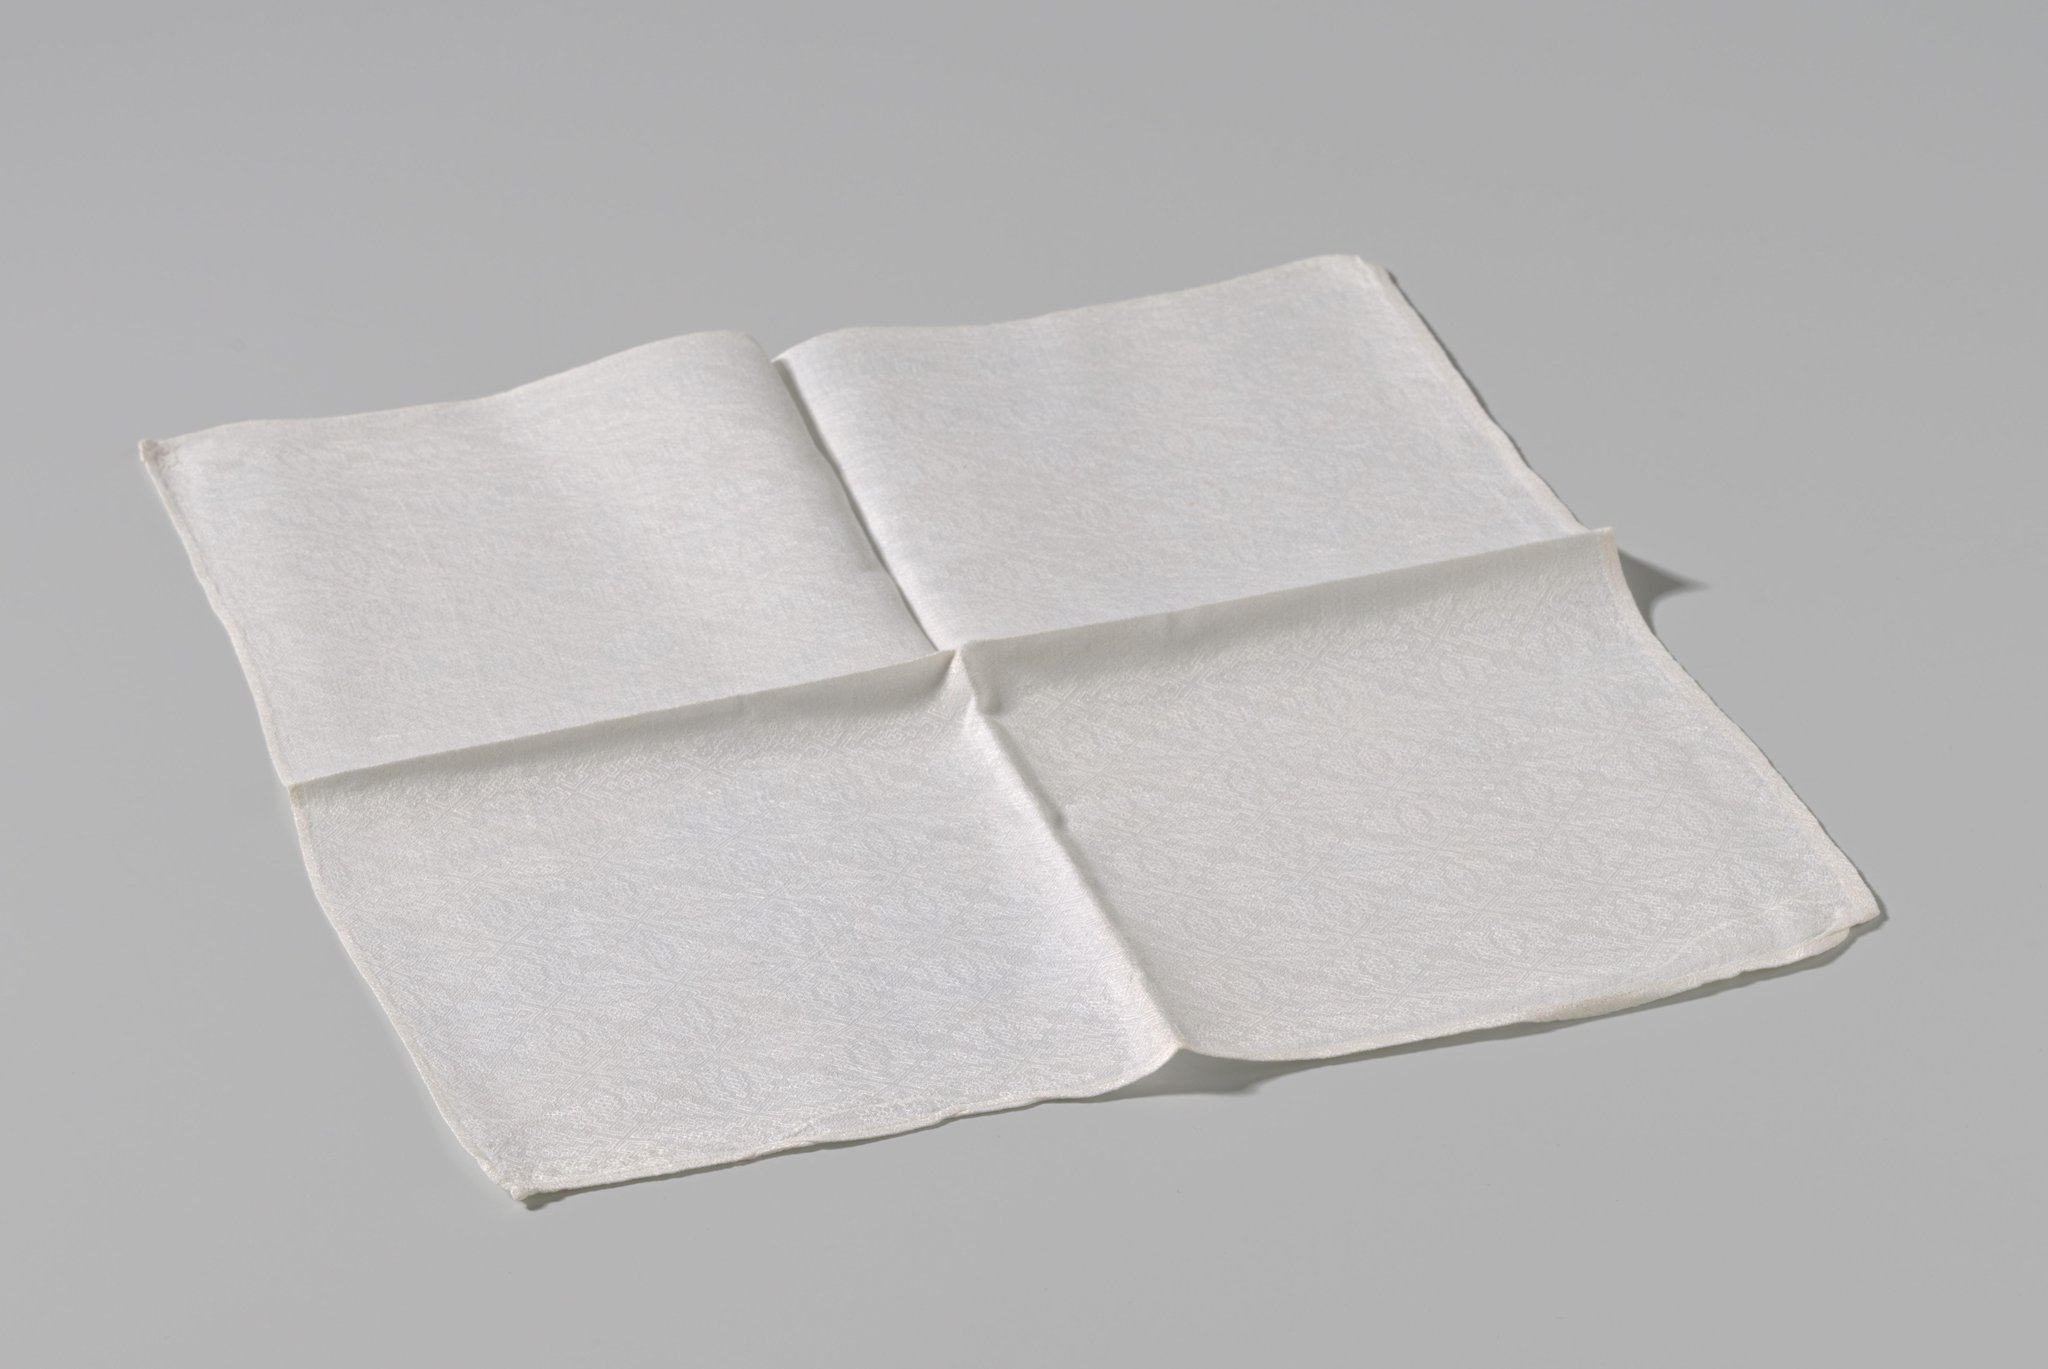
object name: tablecloth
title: Fragment van een servet of tafellaken met kruiswerkpatroon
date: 1600-1650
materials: linen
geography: northern netherlands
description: Fragment van een witlinnen tafellaken of servet met een 'kruiswerk'-patroon.